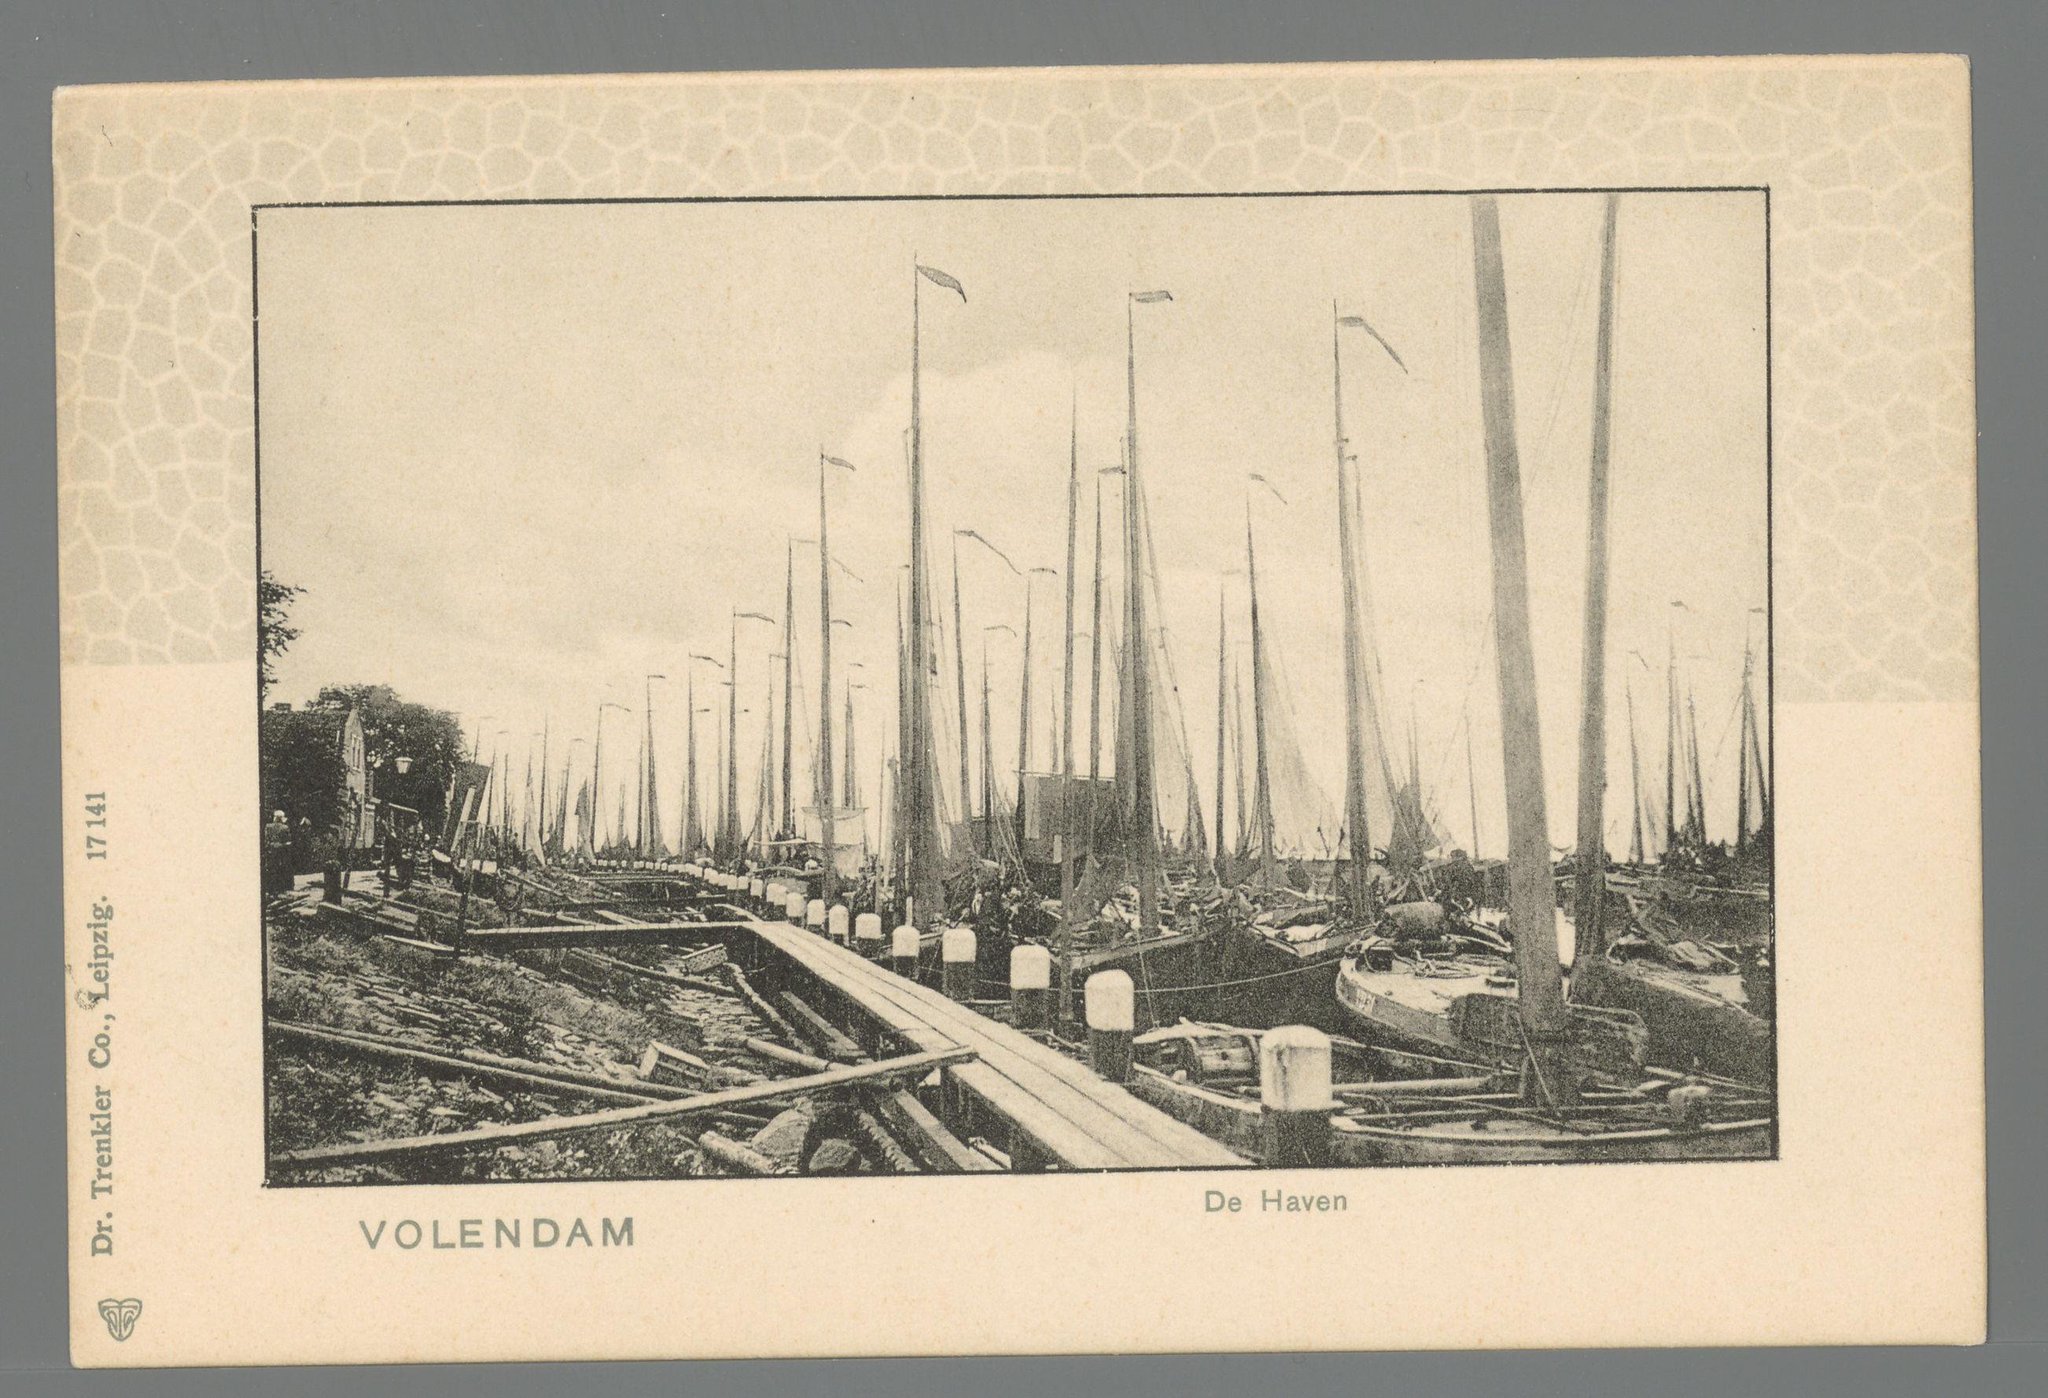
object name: photomechanical print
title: Volendam. De Haven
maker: Anonymous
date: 1894-1905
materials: cardboard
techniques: photograph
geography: volendam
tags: harbour, sailing-ship, sailing-boat